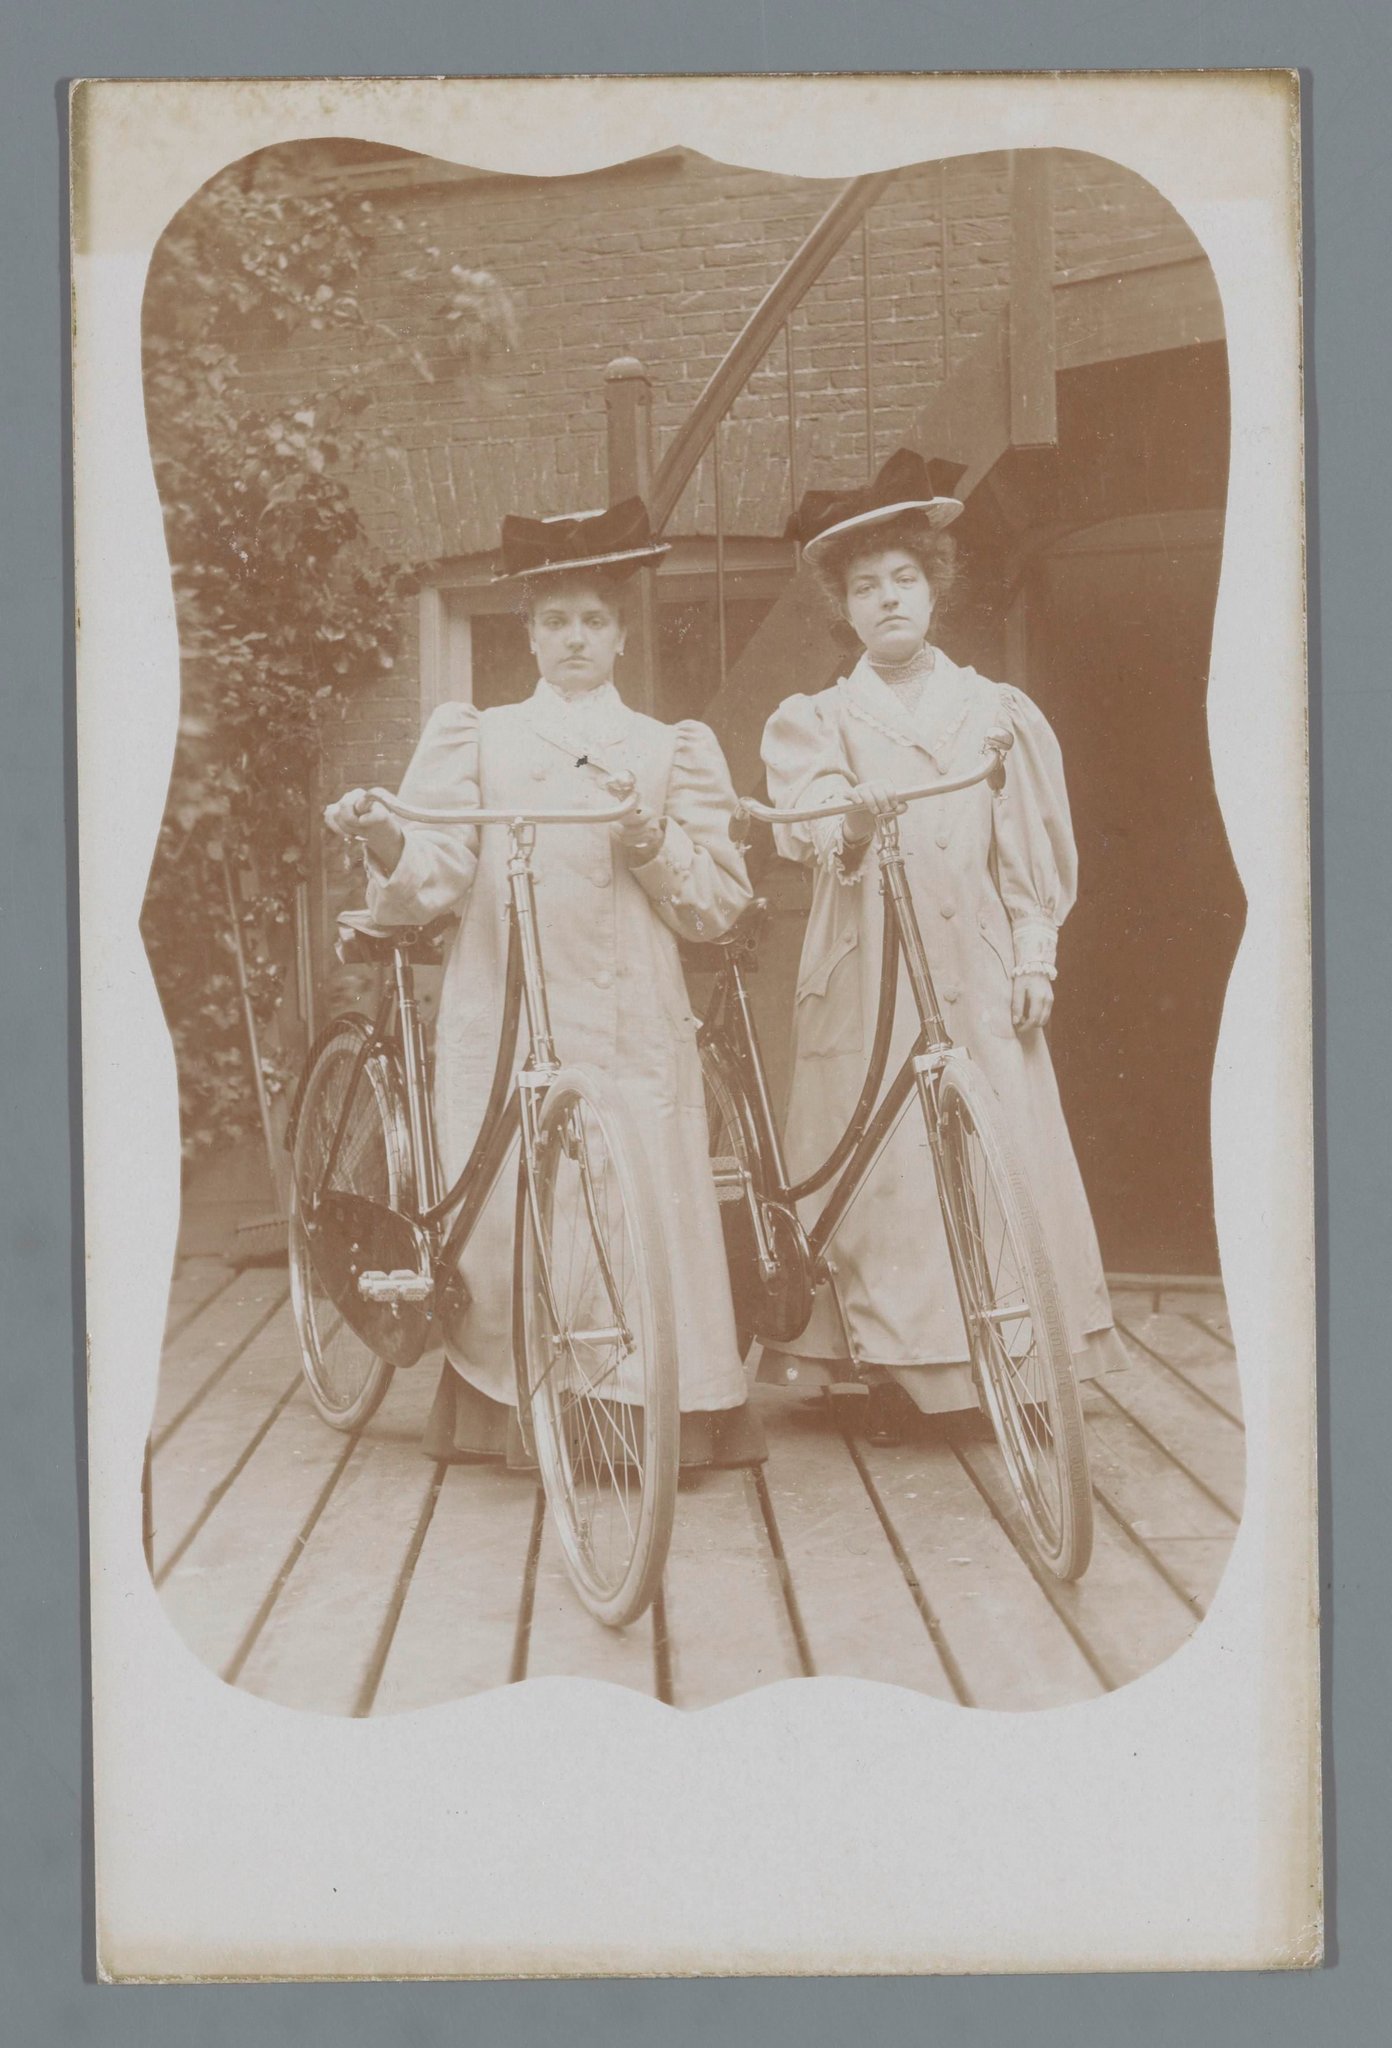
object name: photograph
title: Portret van twee onbekende vrouwen met fietsen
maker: Anonymous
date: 1907-1915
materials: photographic support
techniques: gelatin silver print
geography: netherlands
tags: adolescent, young woman, maiden, bicycle